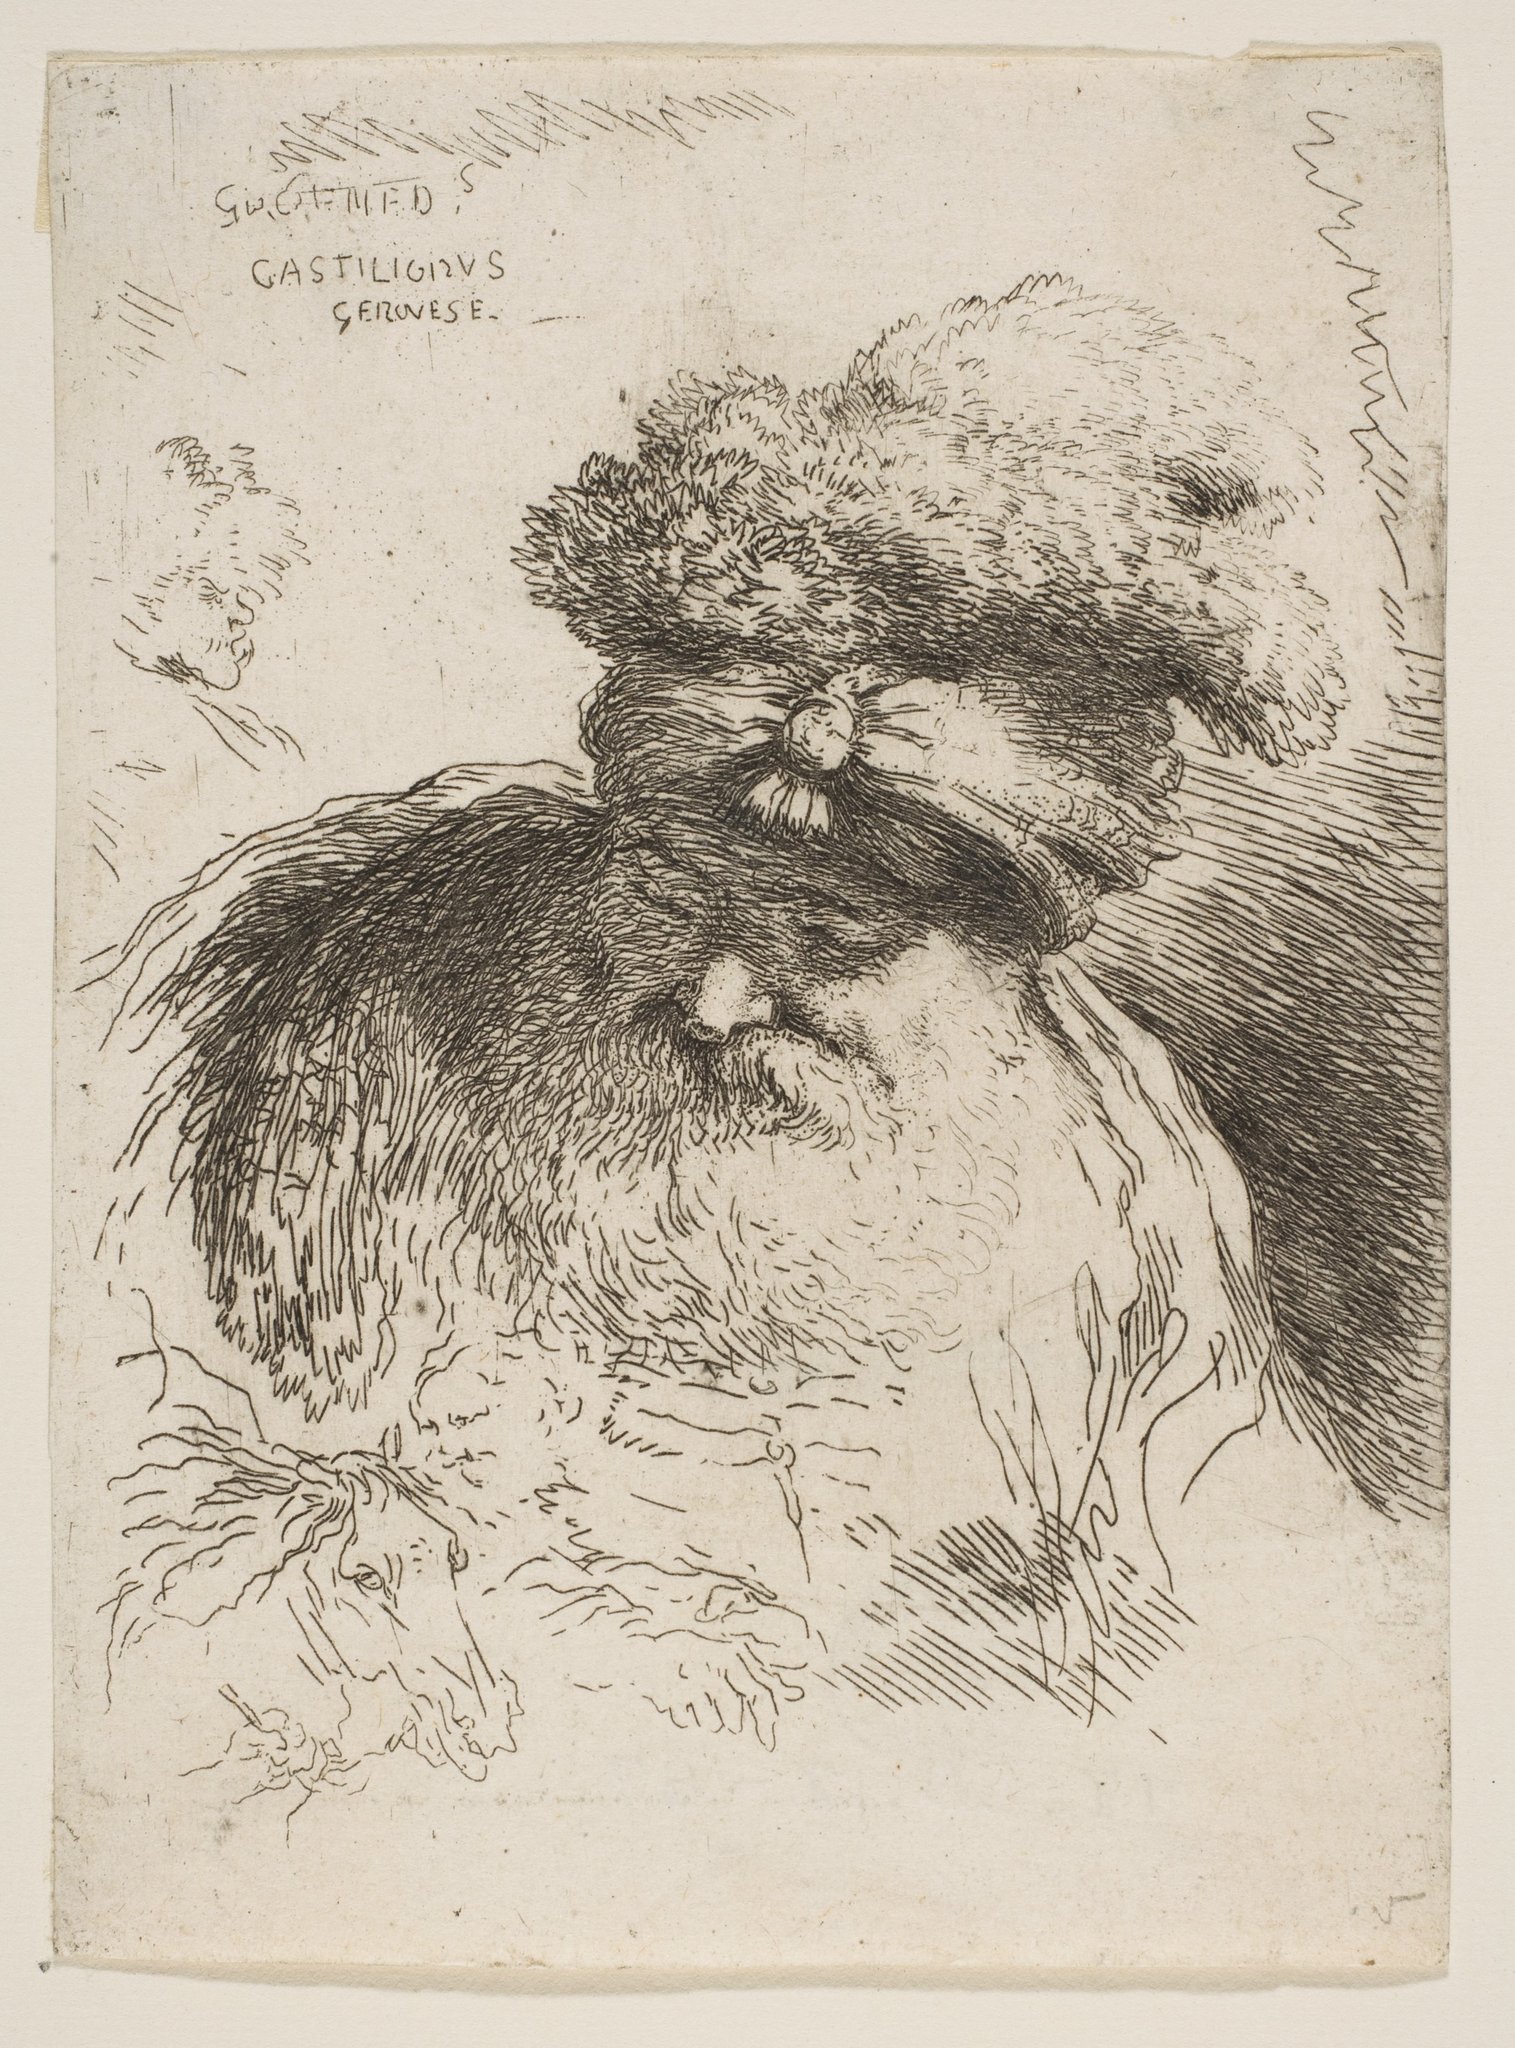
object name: print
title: Head of an old bearded man with a turban, from "Small Heads in Oriental Headdress"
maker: giovanni benedetto castiglione (il grechetto)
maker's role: artist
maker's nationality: italian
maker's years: 1609-1664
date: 1645-1650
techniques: etching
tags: men